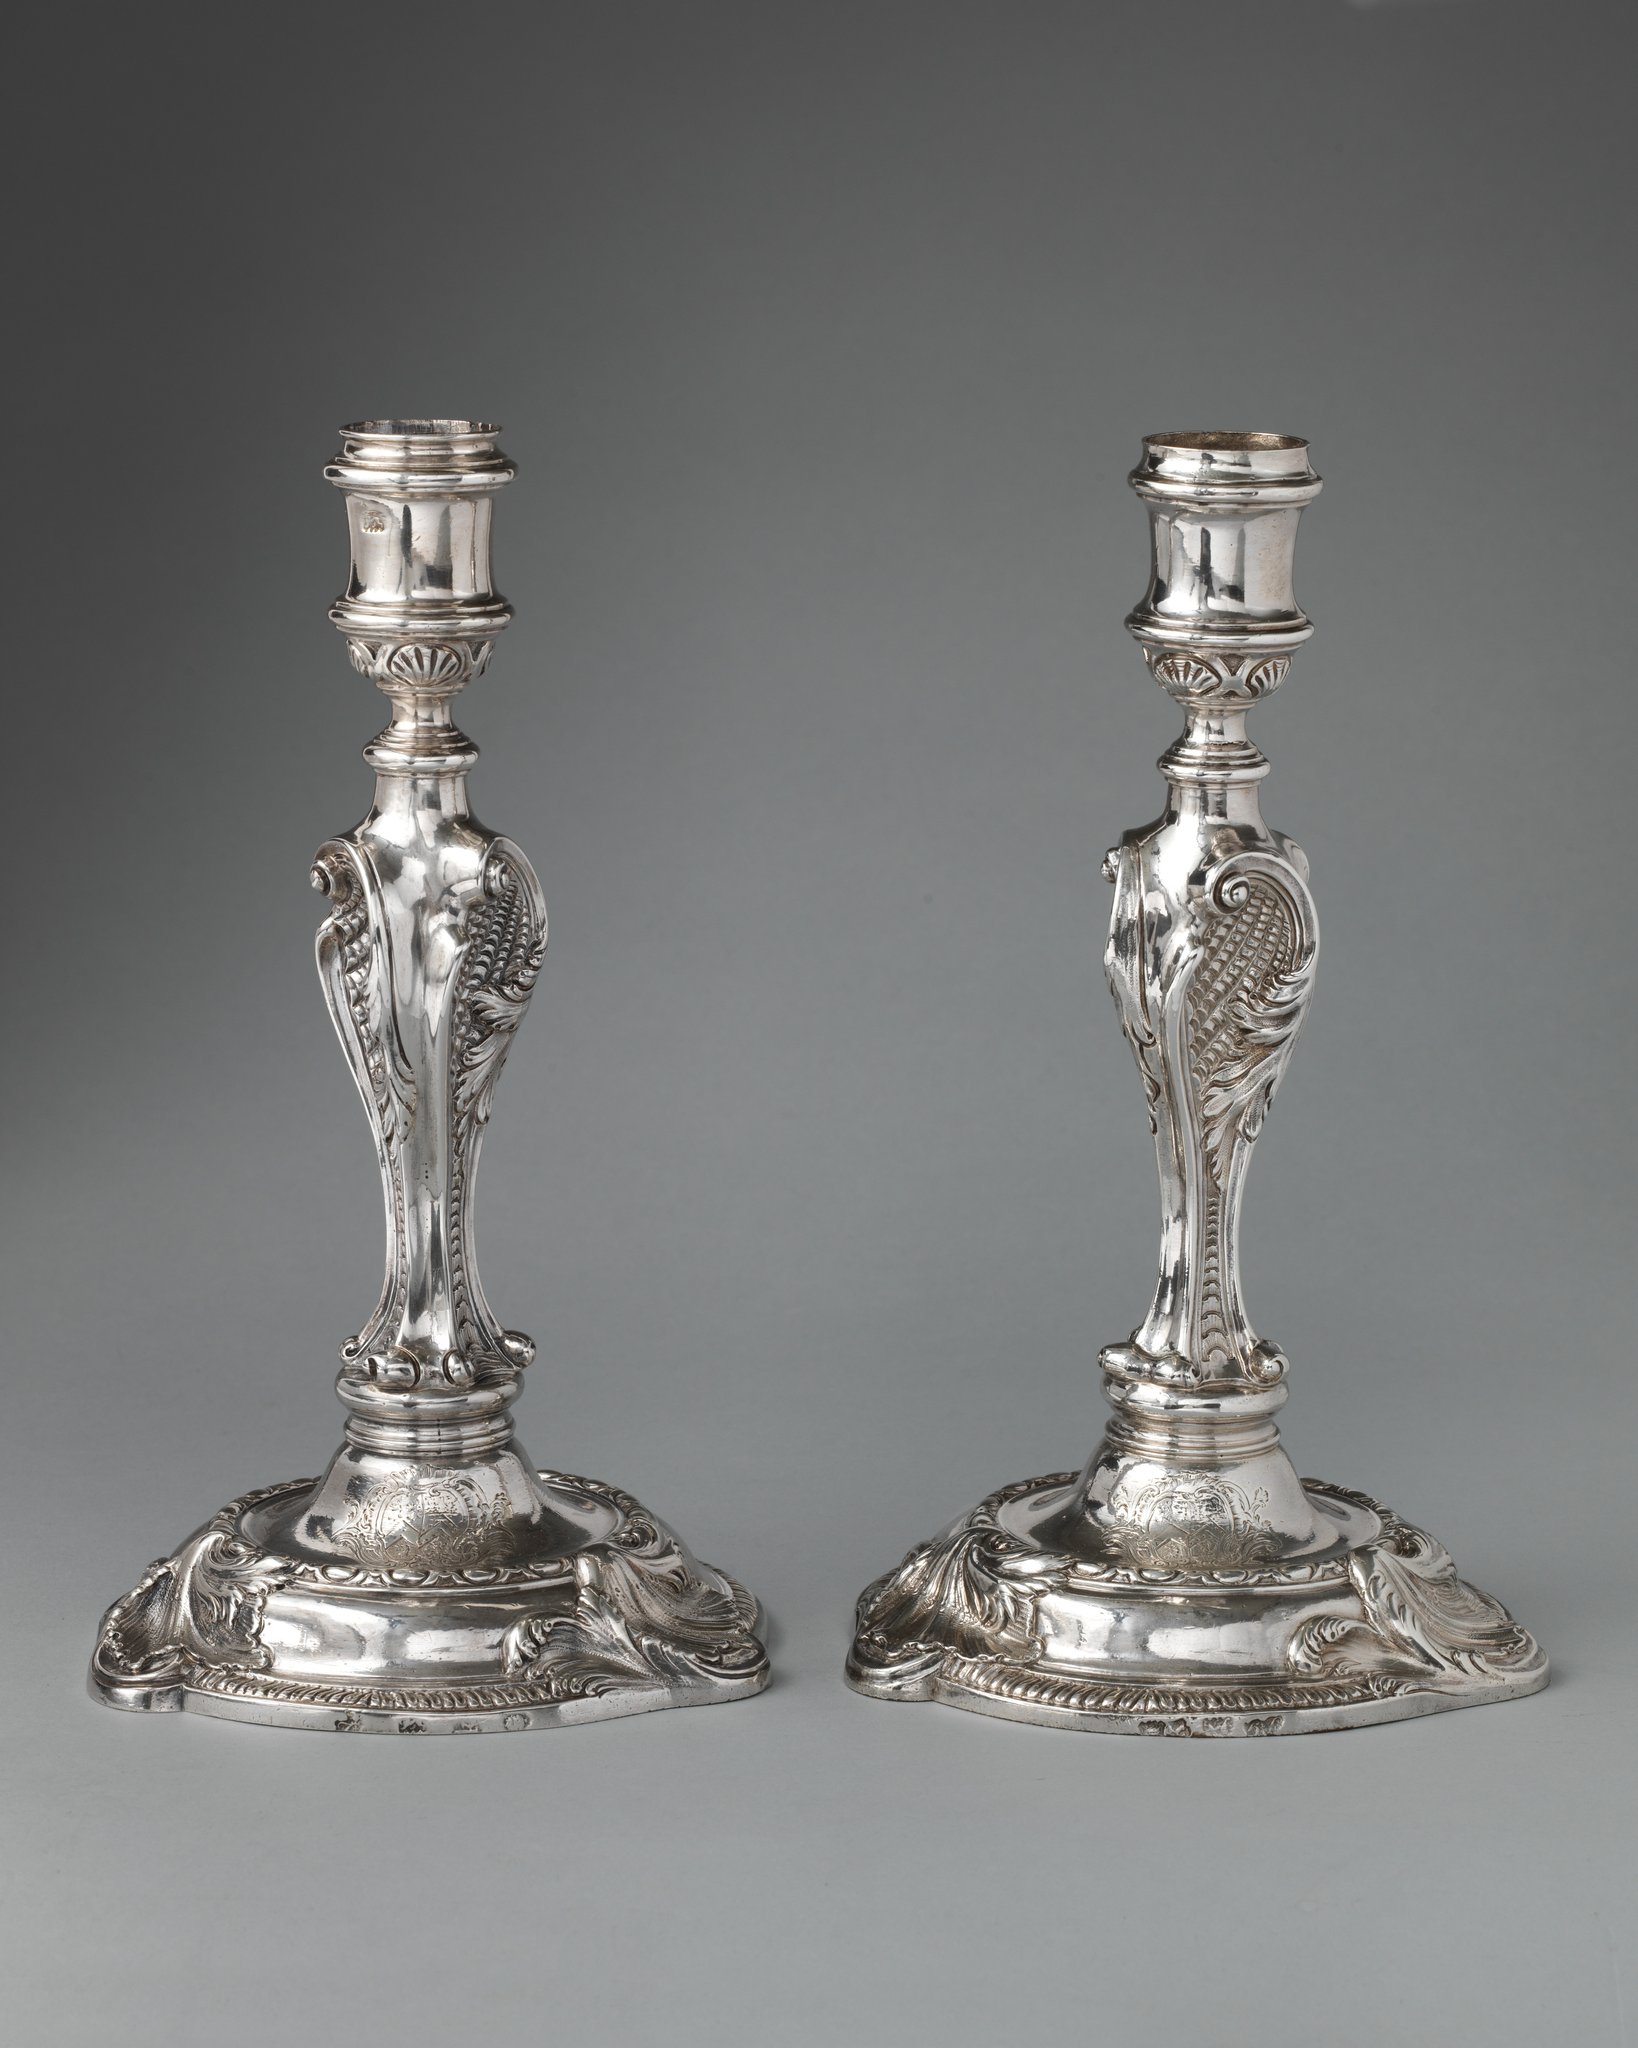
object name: candlestick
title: Pair of candlesticks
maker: thomas gilpin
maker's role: maker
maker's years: 1730-1773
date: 1745-1746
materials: silver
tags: coat of arms